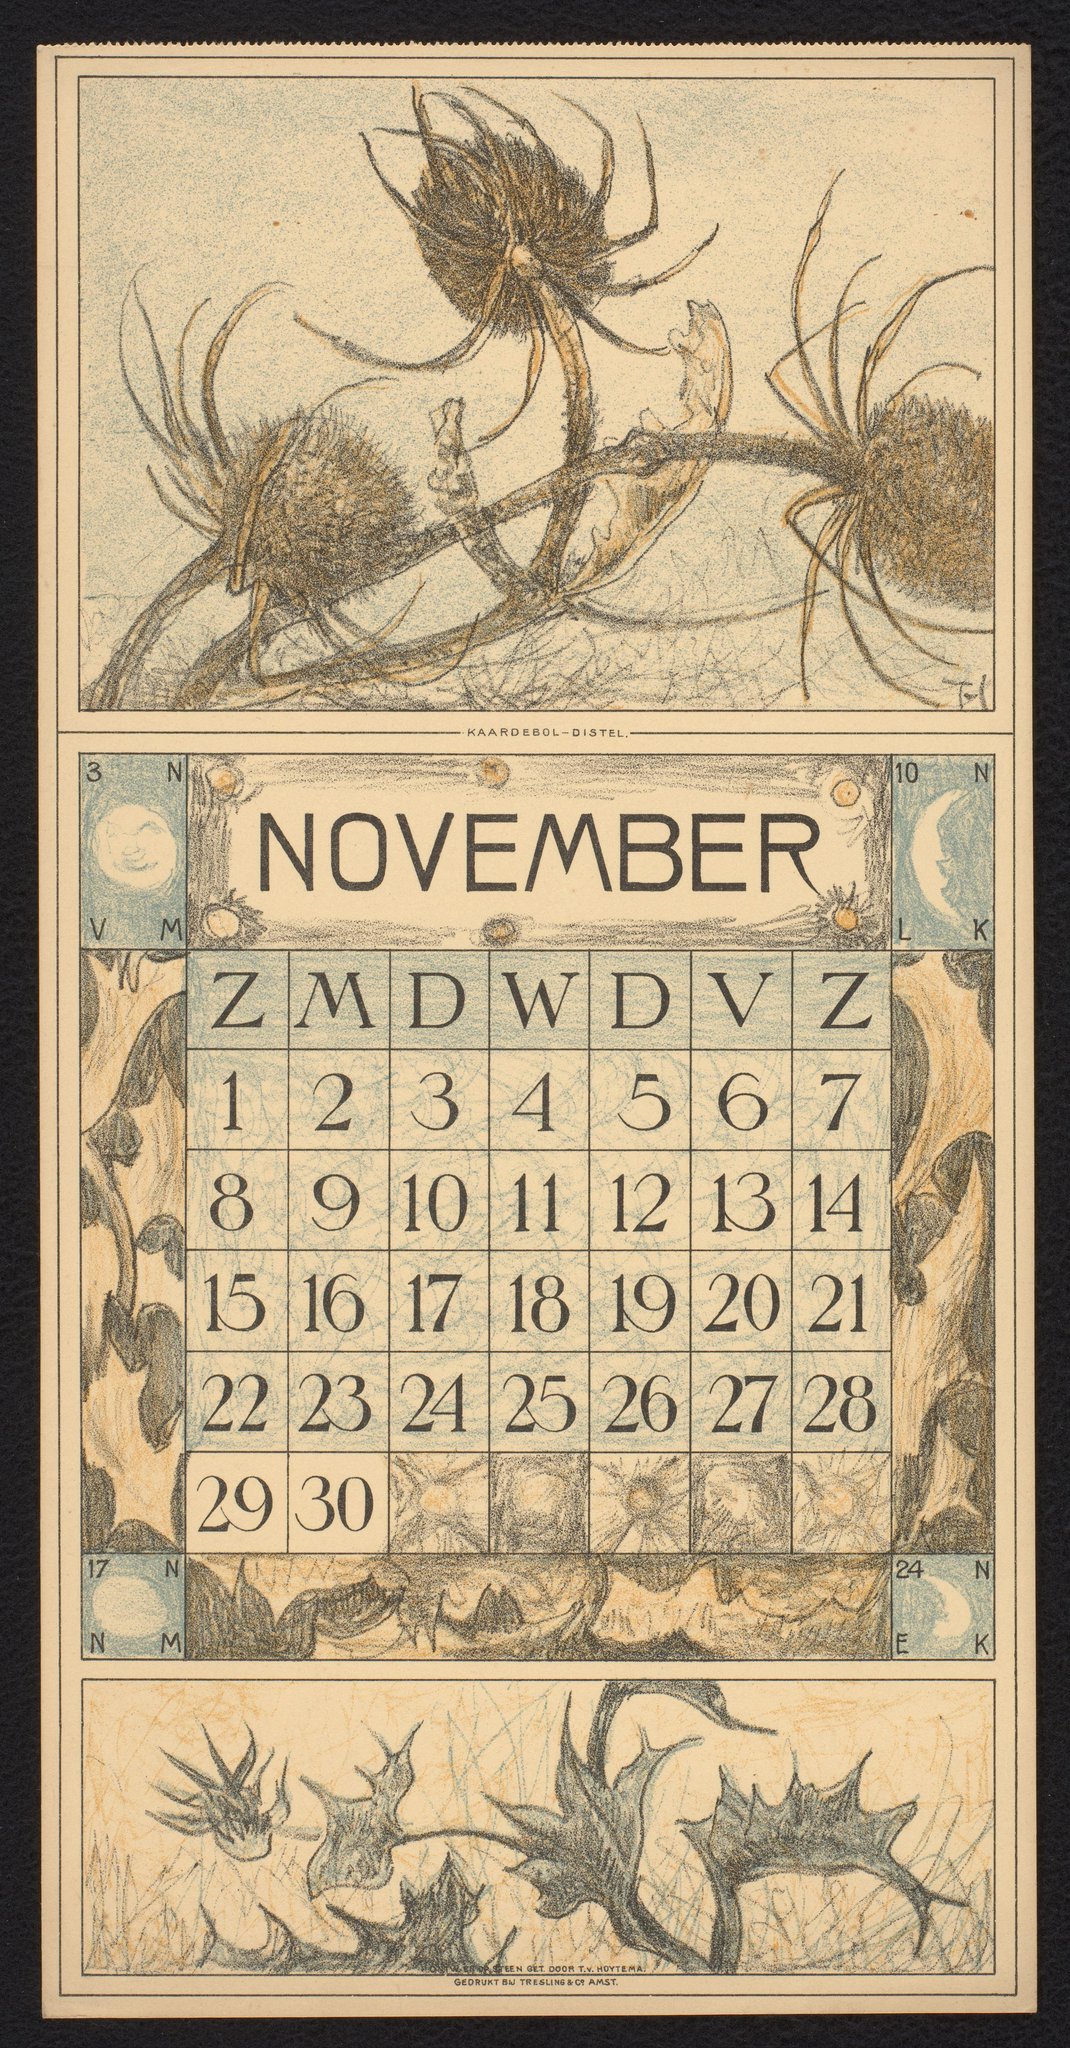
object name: calendar leaf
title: Kalenderblad voor november 1914 met een kaardebol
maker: theo van hoytema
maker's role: draughtsman, painter, print maker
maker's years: 1863-1917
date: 1913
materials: paper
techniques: lithograph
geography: amsterdam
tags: plants (in general), calendar, almanac